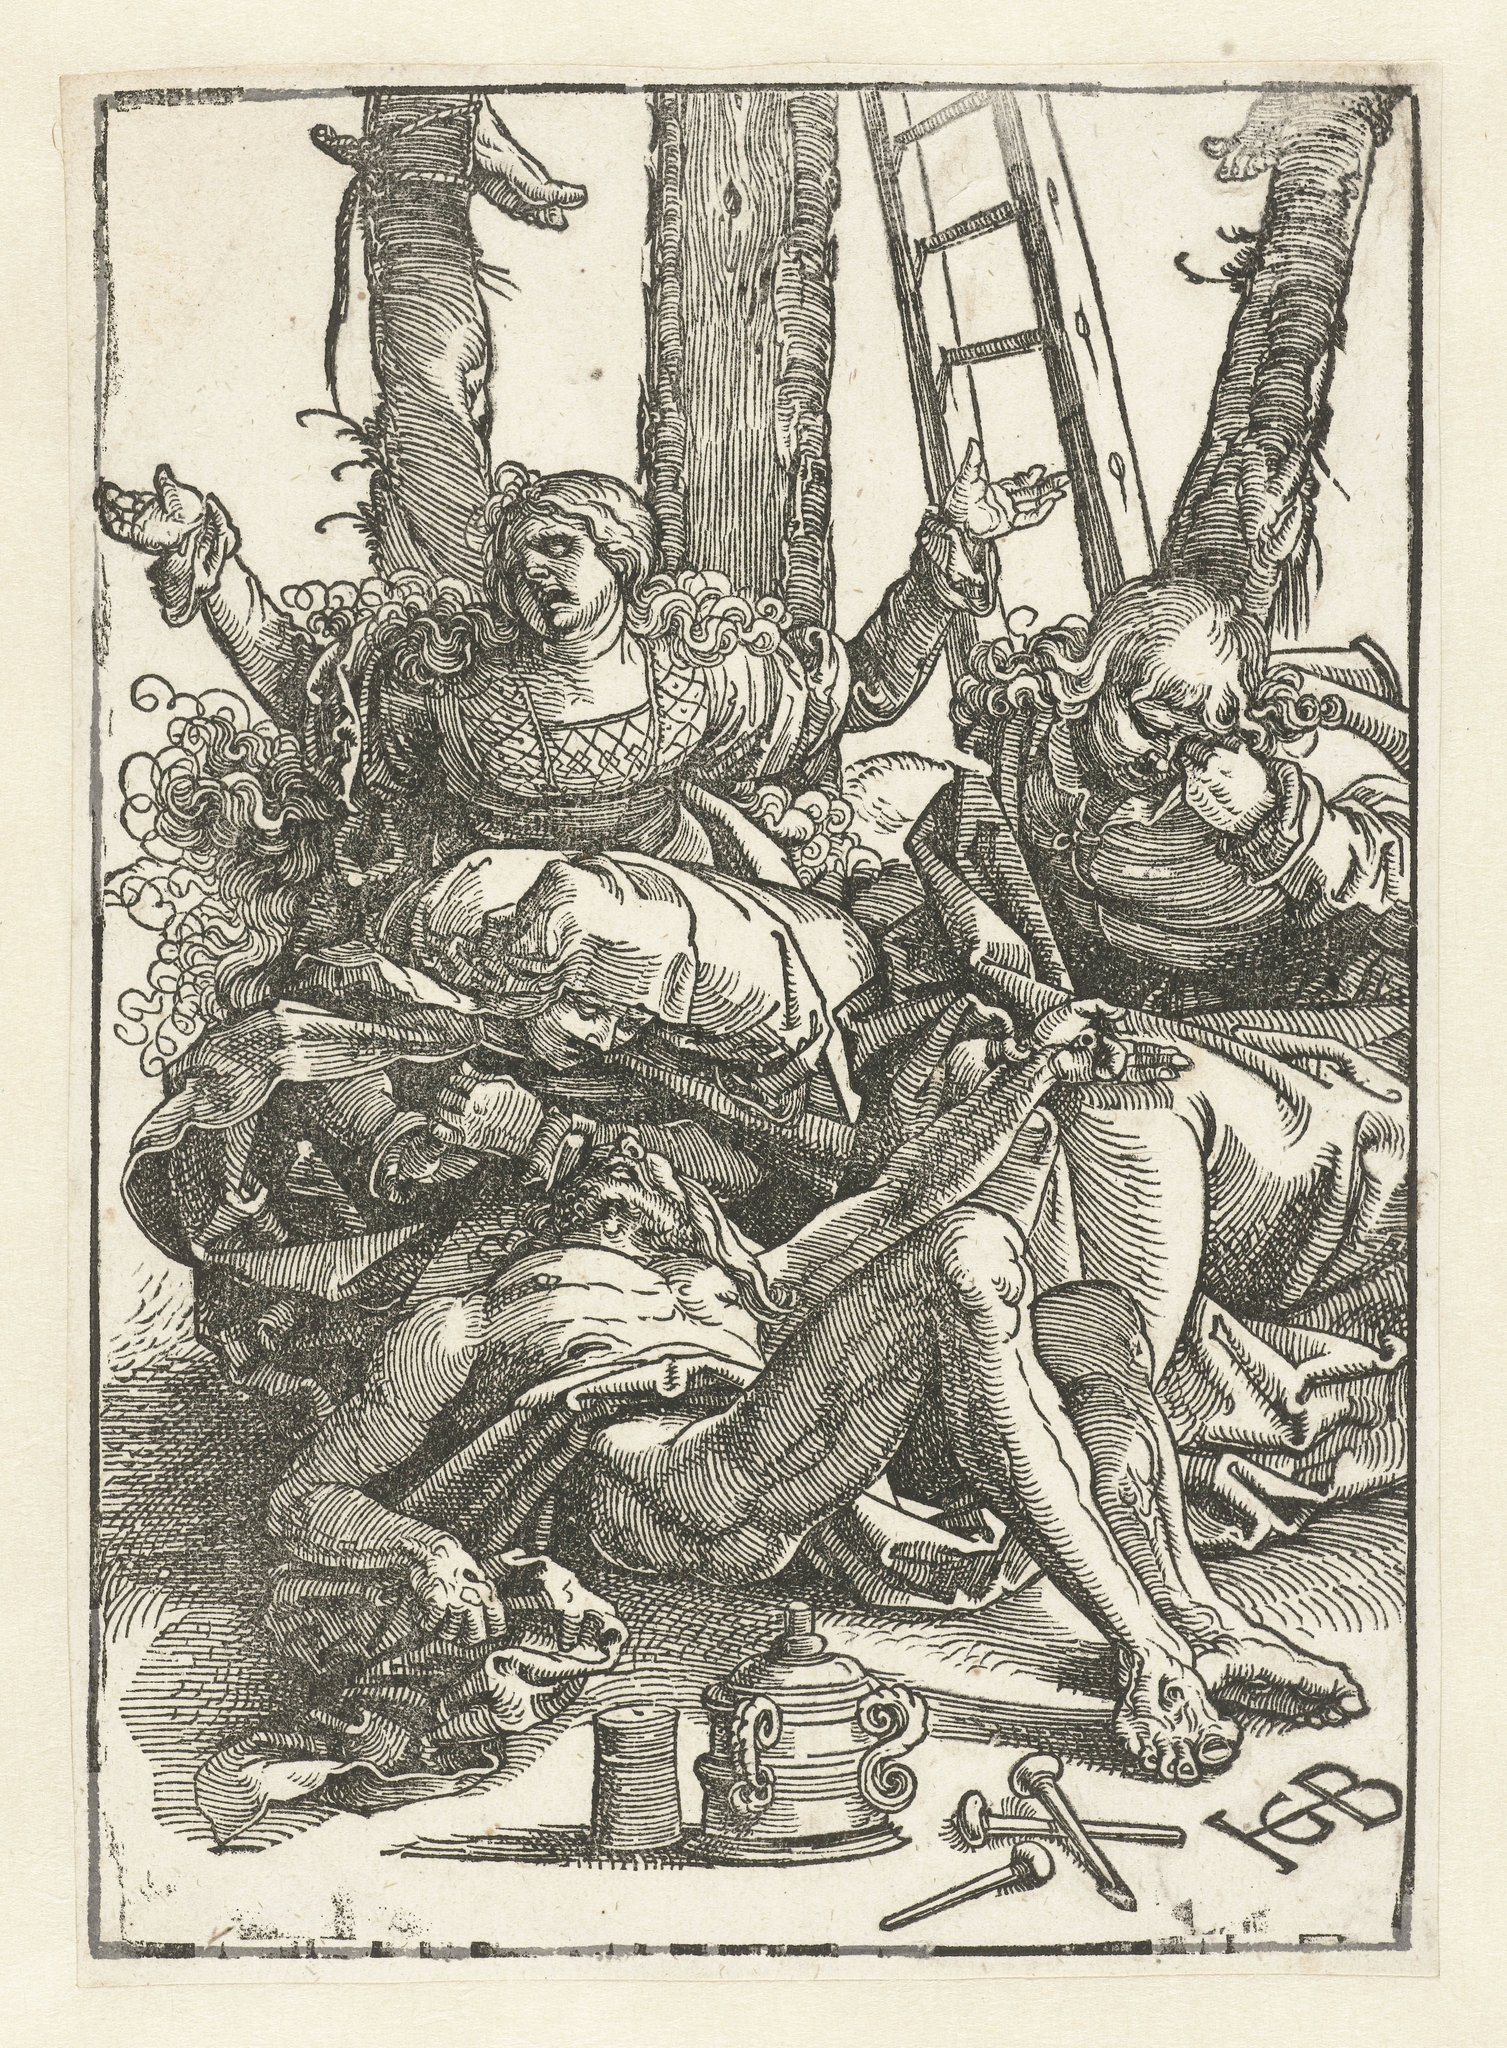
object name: print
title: Bewening van Christus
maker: hans baldung grien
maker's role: draughtsman, print maker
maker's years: 1484-1545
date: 1515-1517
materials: paper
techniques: woodcut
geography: freiburg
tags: lamentation over the dead christ by his relatives and friends (christ usually without crown of thorns)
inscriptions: collector's mark: Lugt 240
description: Het dode lichaam van Christus is van het kruis genomen en ligt aan de voet van het kruis. Maria buigt zich over haar zoon en Johannes zit huilend naast haar. Achter hen heft Maria Magadalena in wanhoop haar armen op. Op de voorgrond liggen nagels en staat een zalfpot.